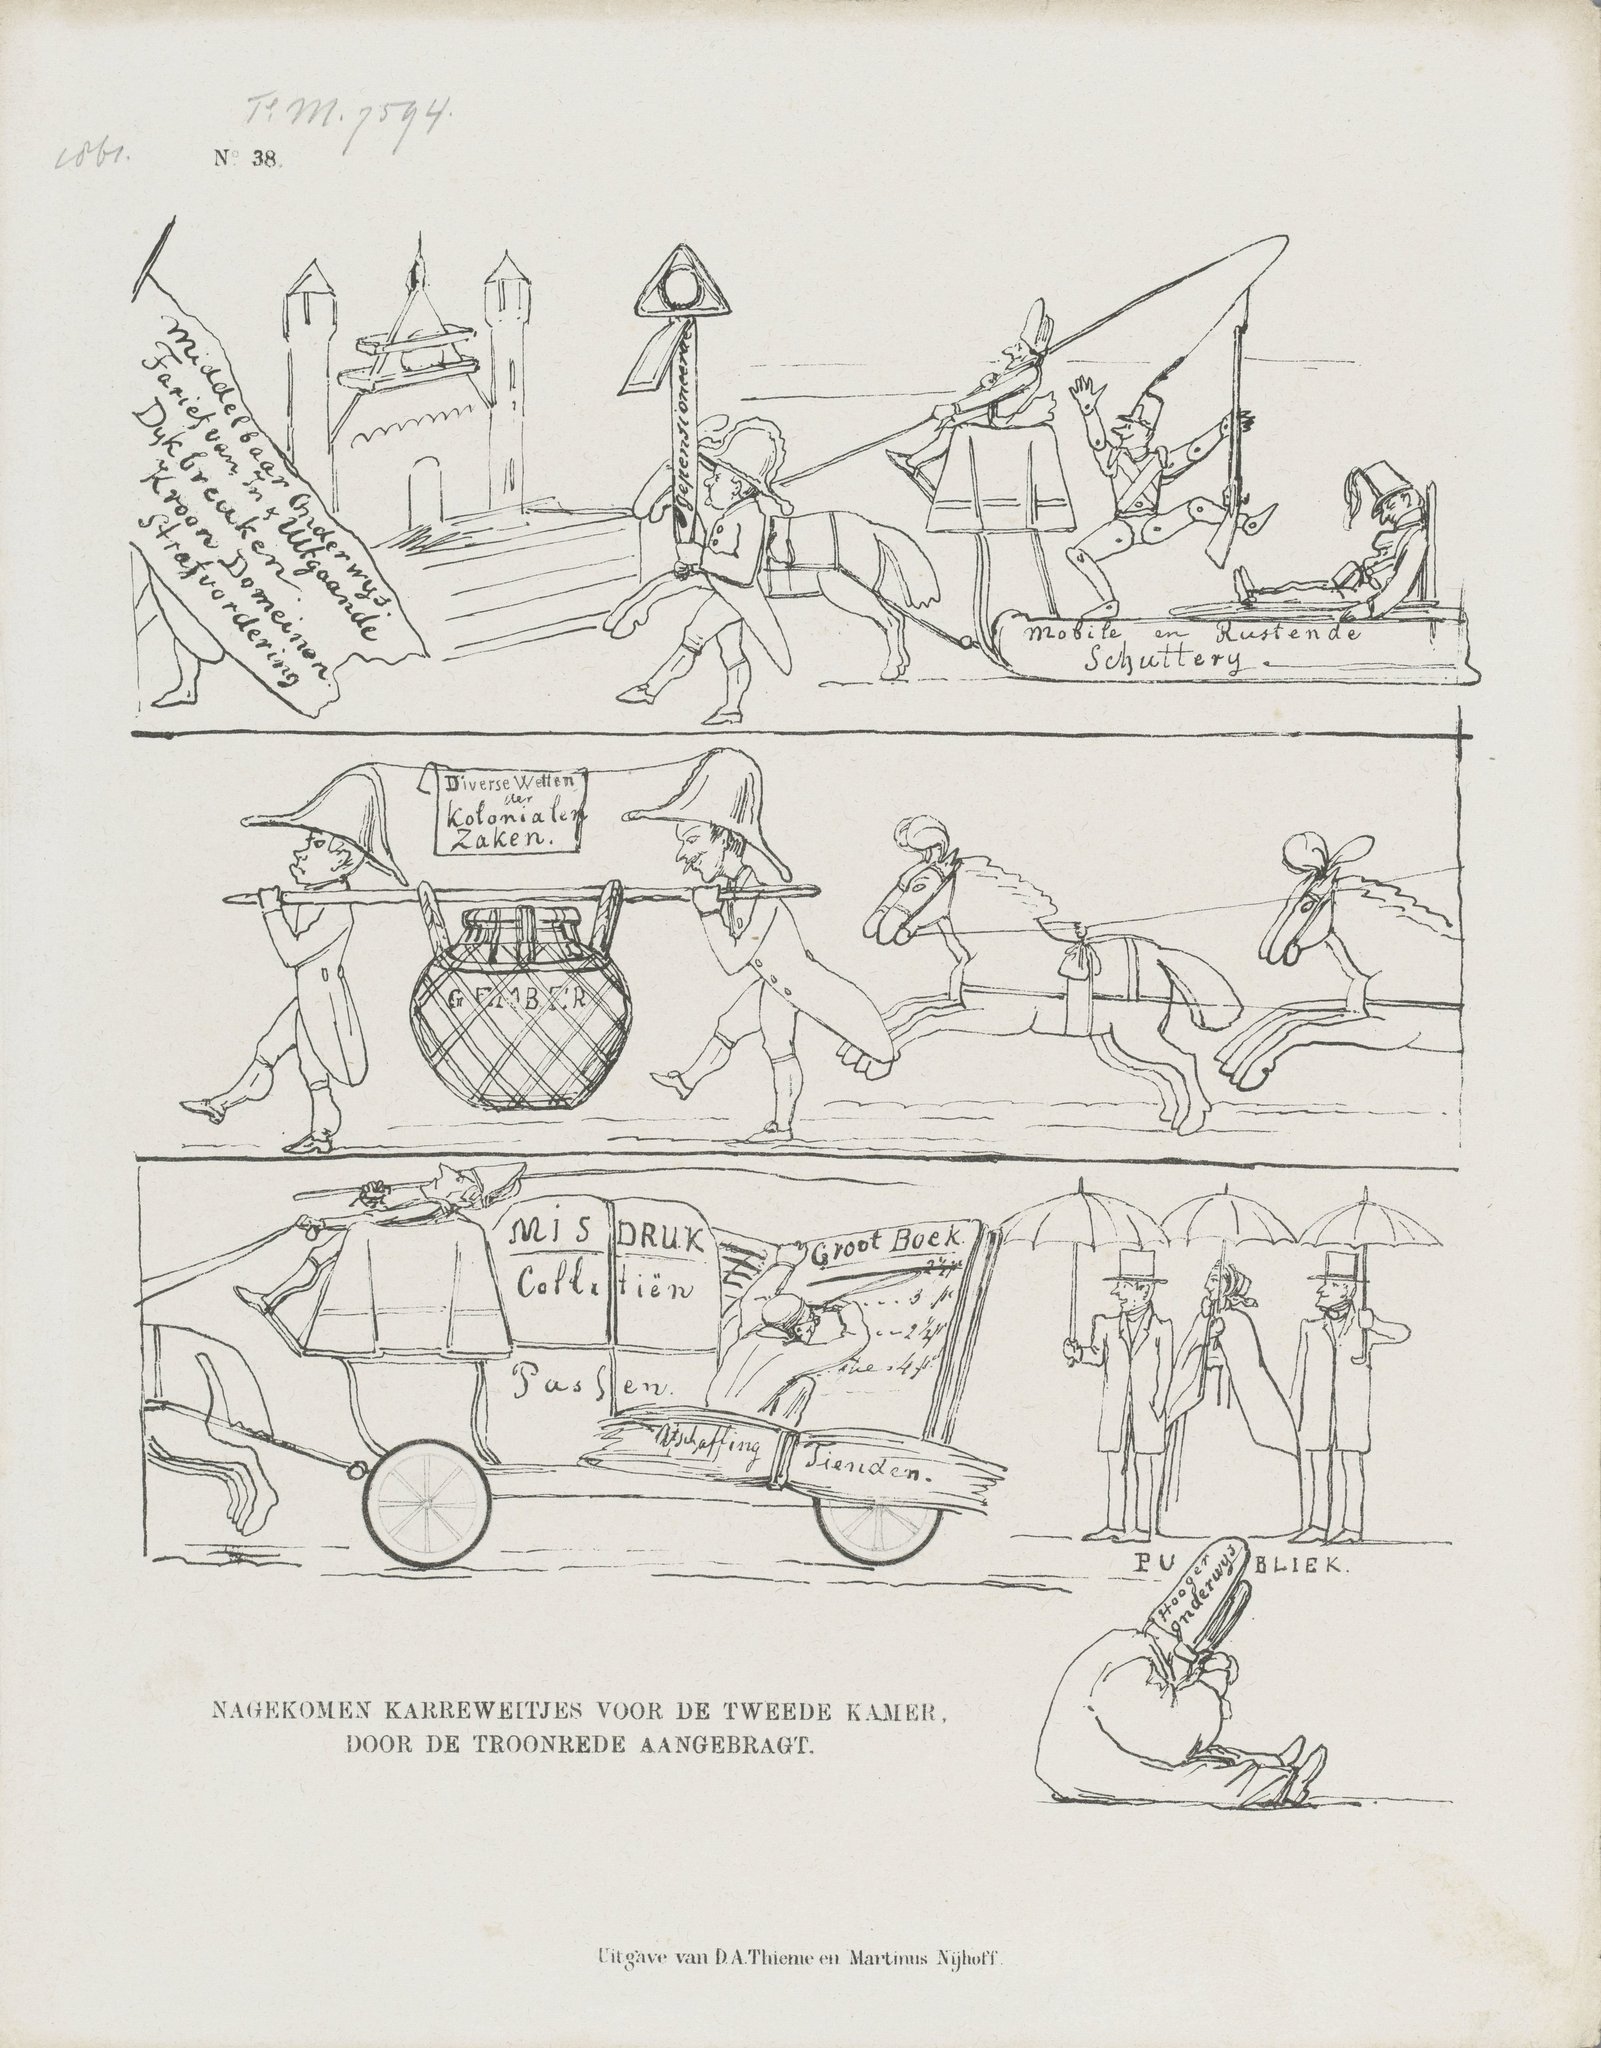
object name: cartoon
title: Nagekomen karreweitjes voor de Tweede Kamer, door de troonrede aangebragt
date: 1861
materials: paper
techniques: lithograph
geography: netherlands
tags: staten-generaal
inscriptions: collector's mark: Lugt 2228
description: Spotprent waarin alle extra wetsontwerpen en andere zaken die door de nieuwe Staten-Generaal behandeld moeten worden in een optocht voorbij komen. Plaat verschenen bij het weekblad De Nederlandsche Spectator, nr. 38, 21 september 1861.